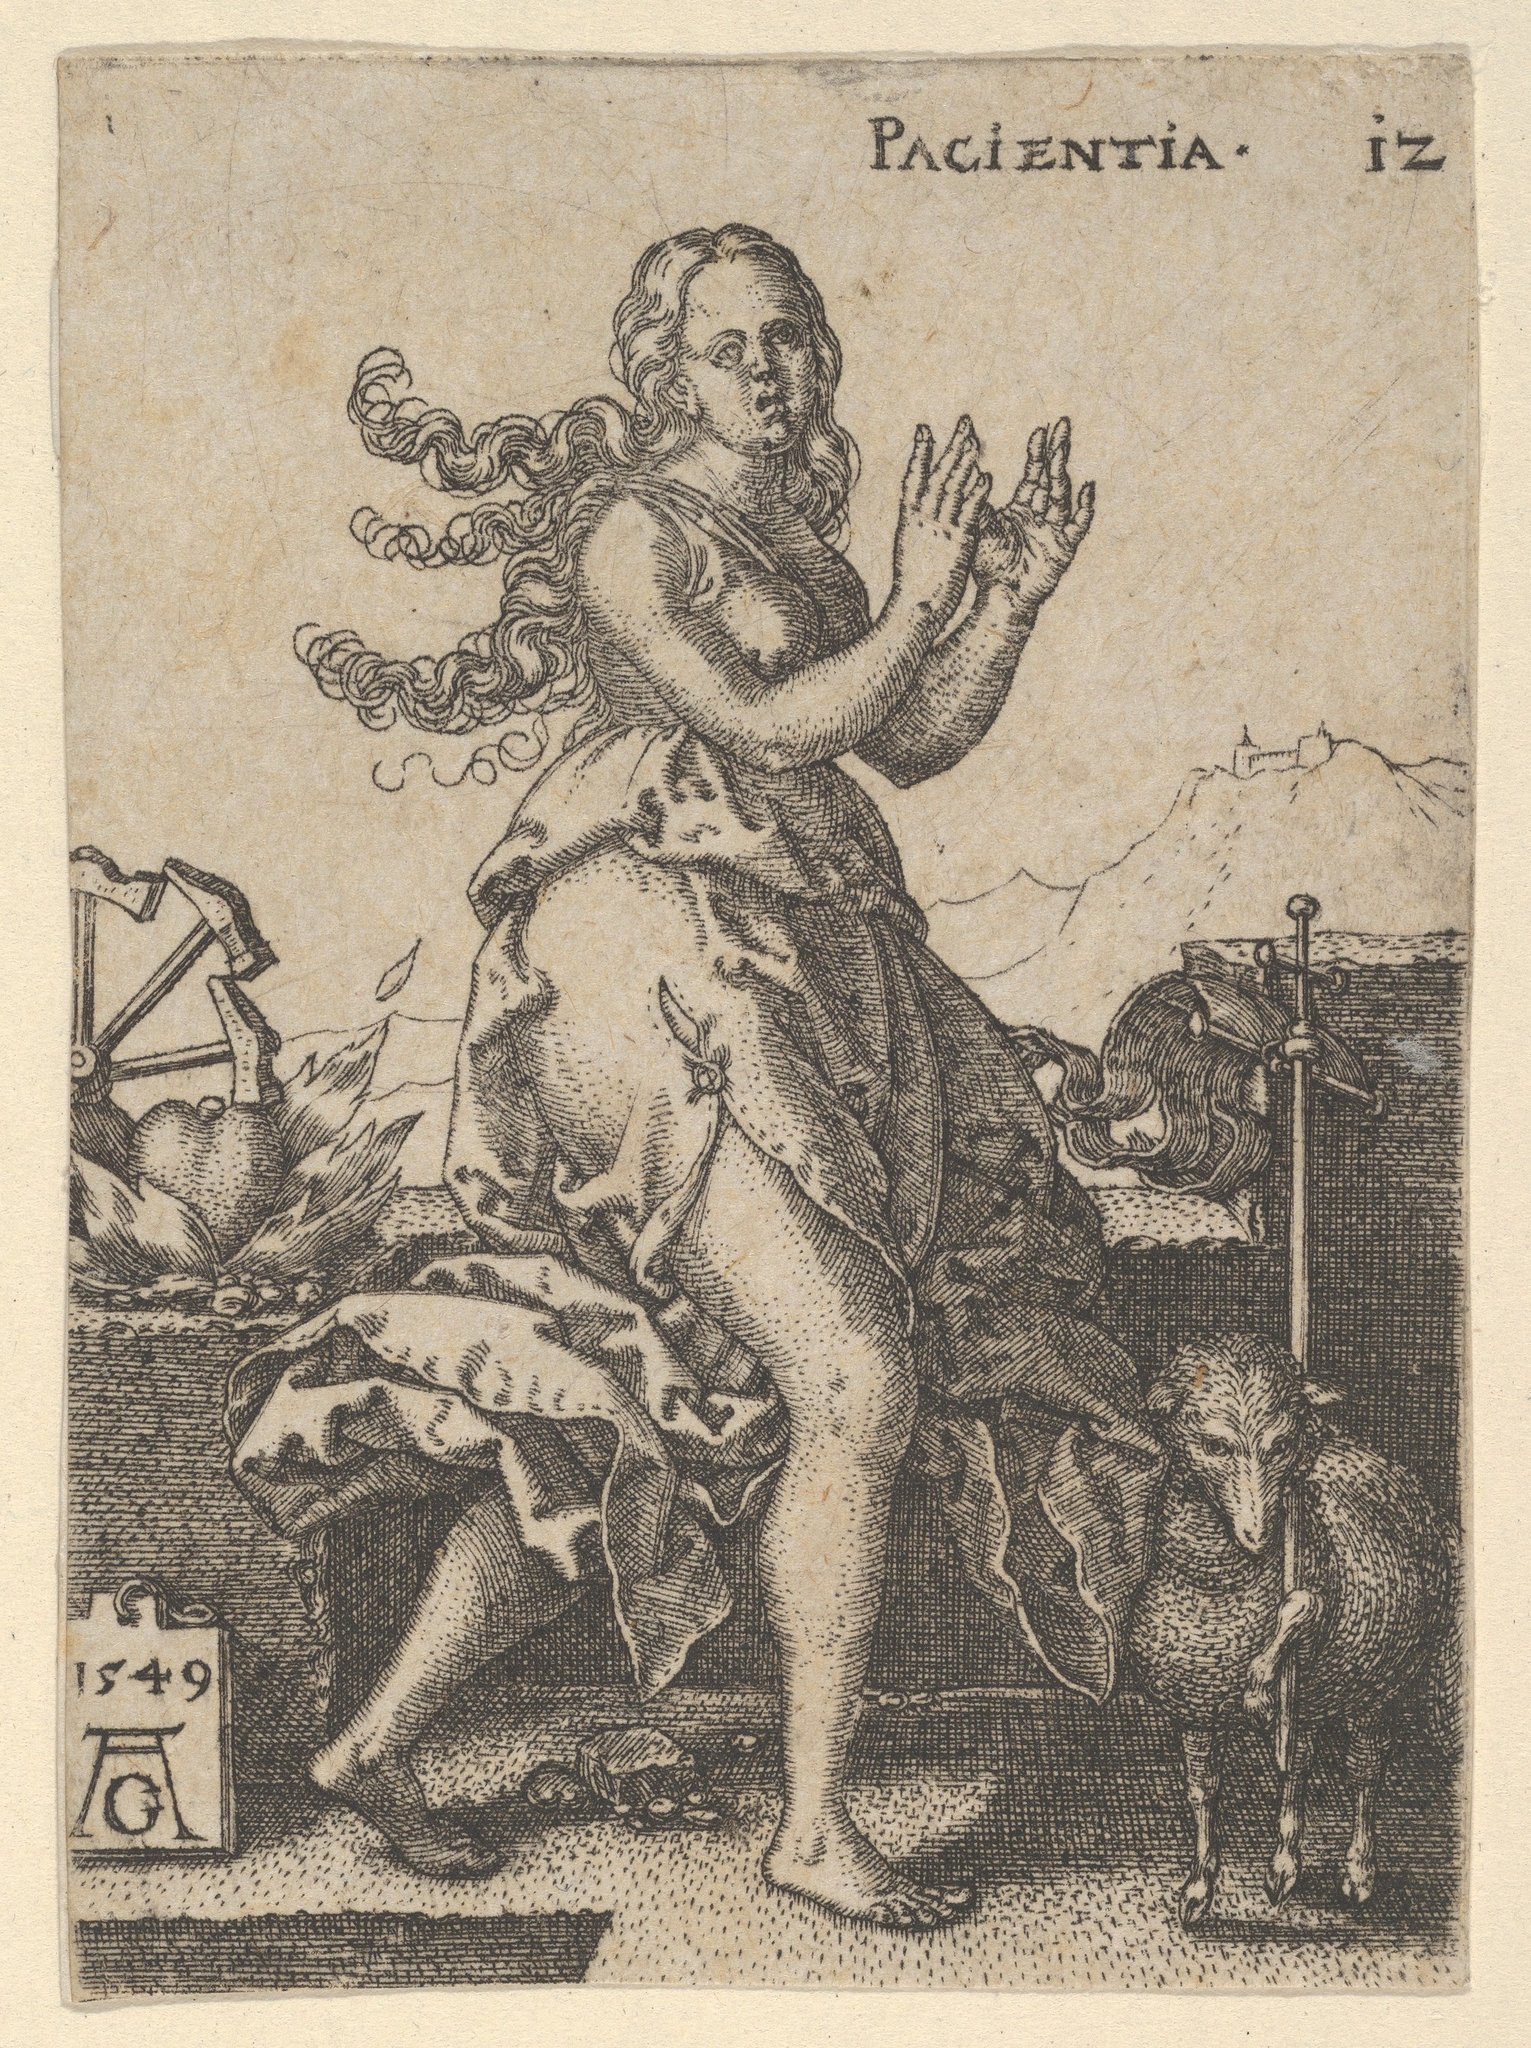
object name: print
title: Patience, from "Virtues and Vices"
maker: heinrich aldegrever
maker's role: artist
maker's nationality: german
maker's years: 1502-1561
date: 1549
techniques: engraving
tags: women,lambs